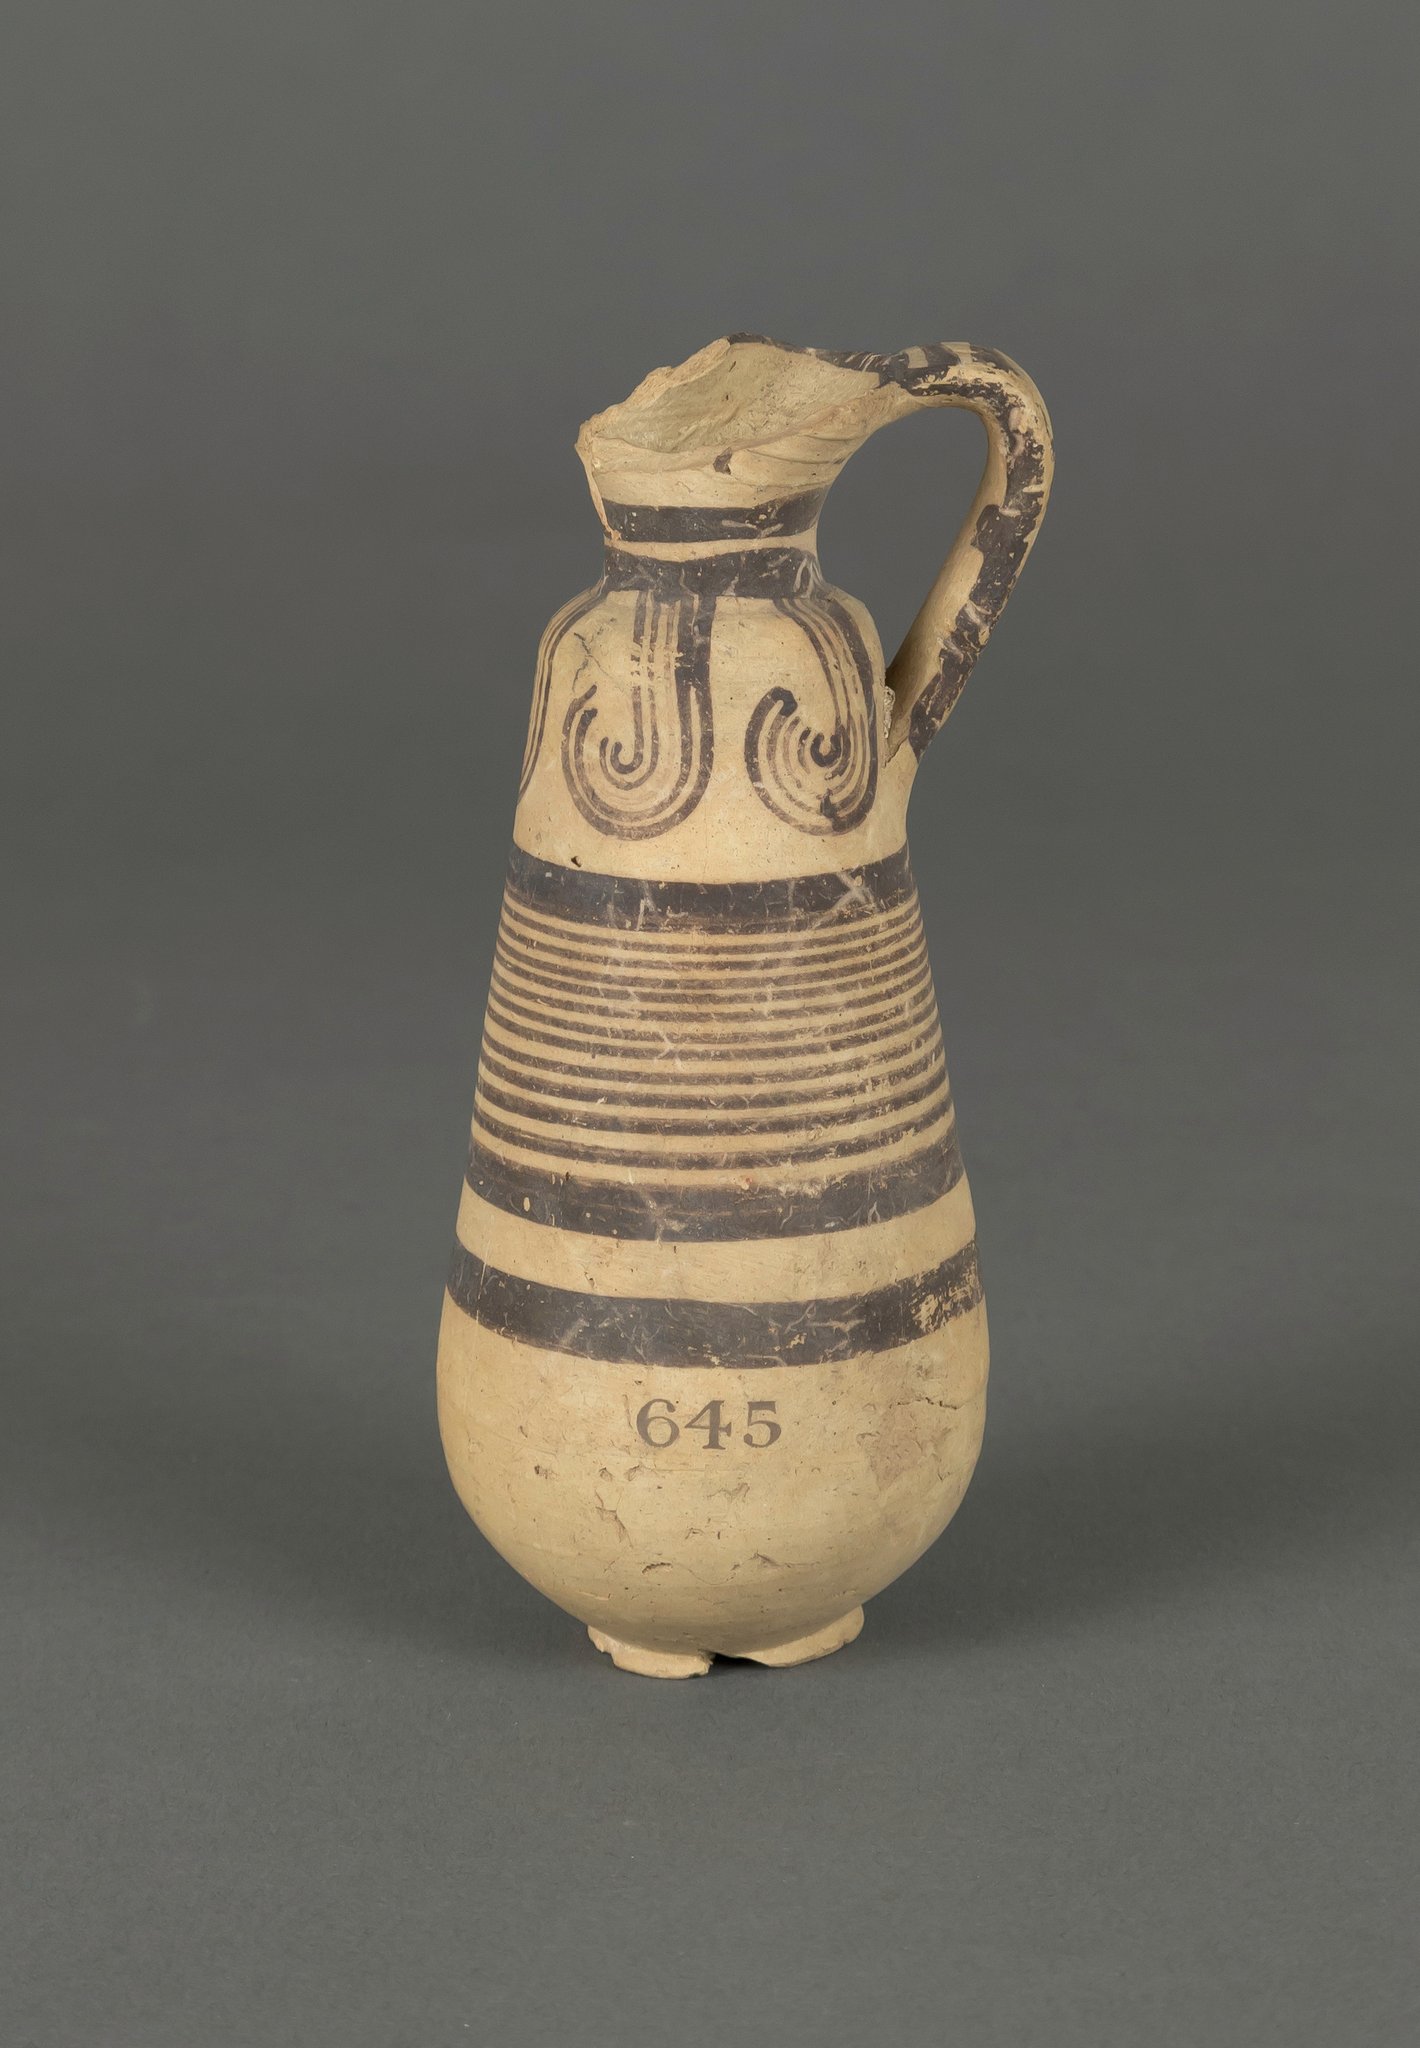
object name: jug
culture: cypriot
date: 1050-900 BCE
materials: terracotta